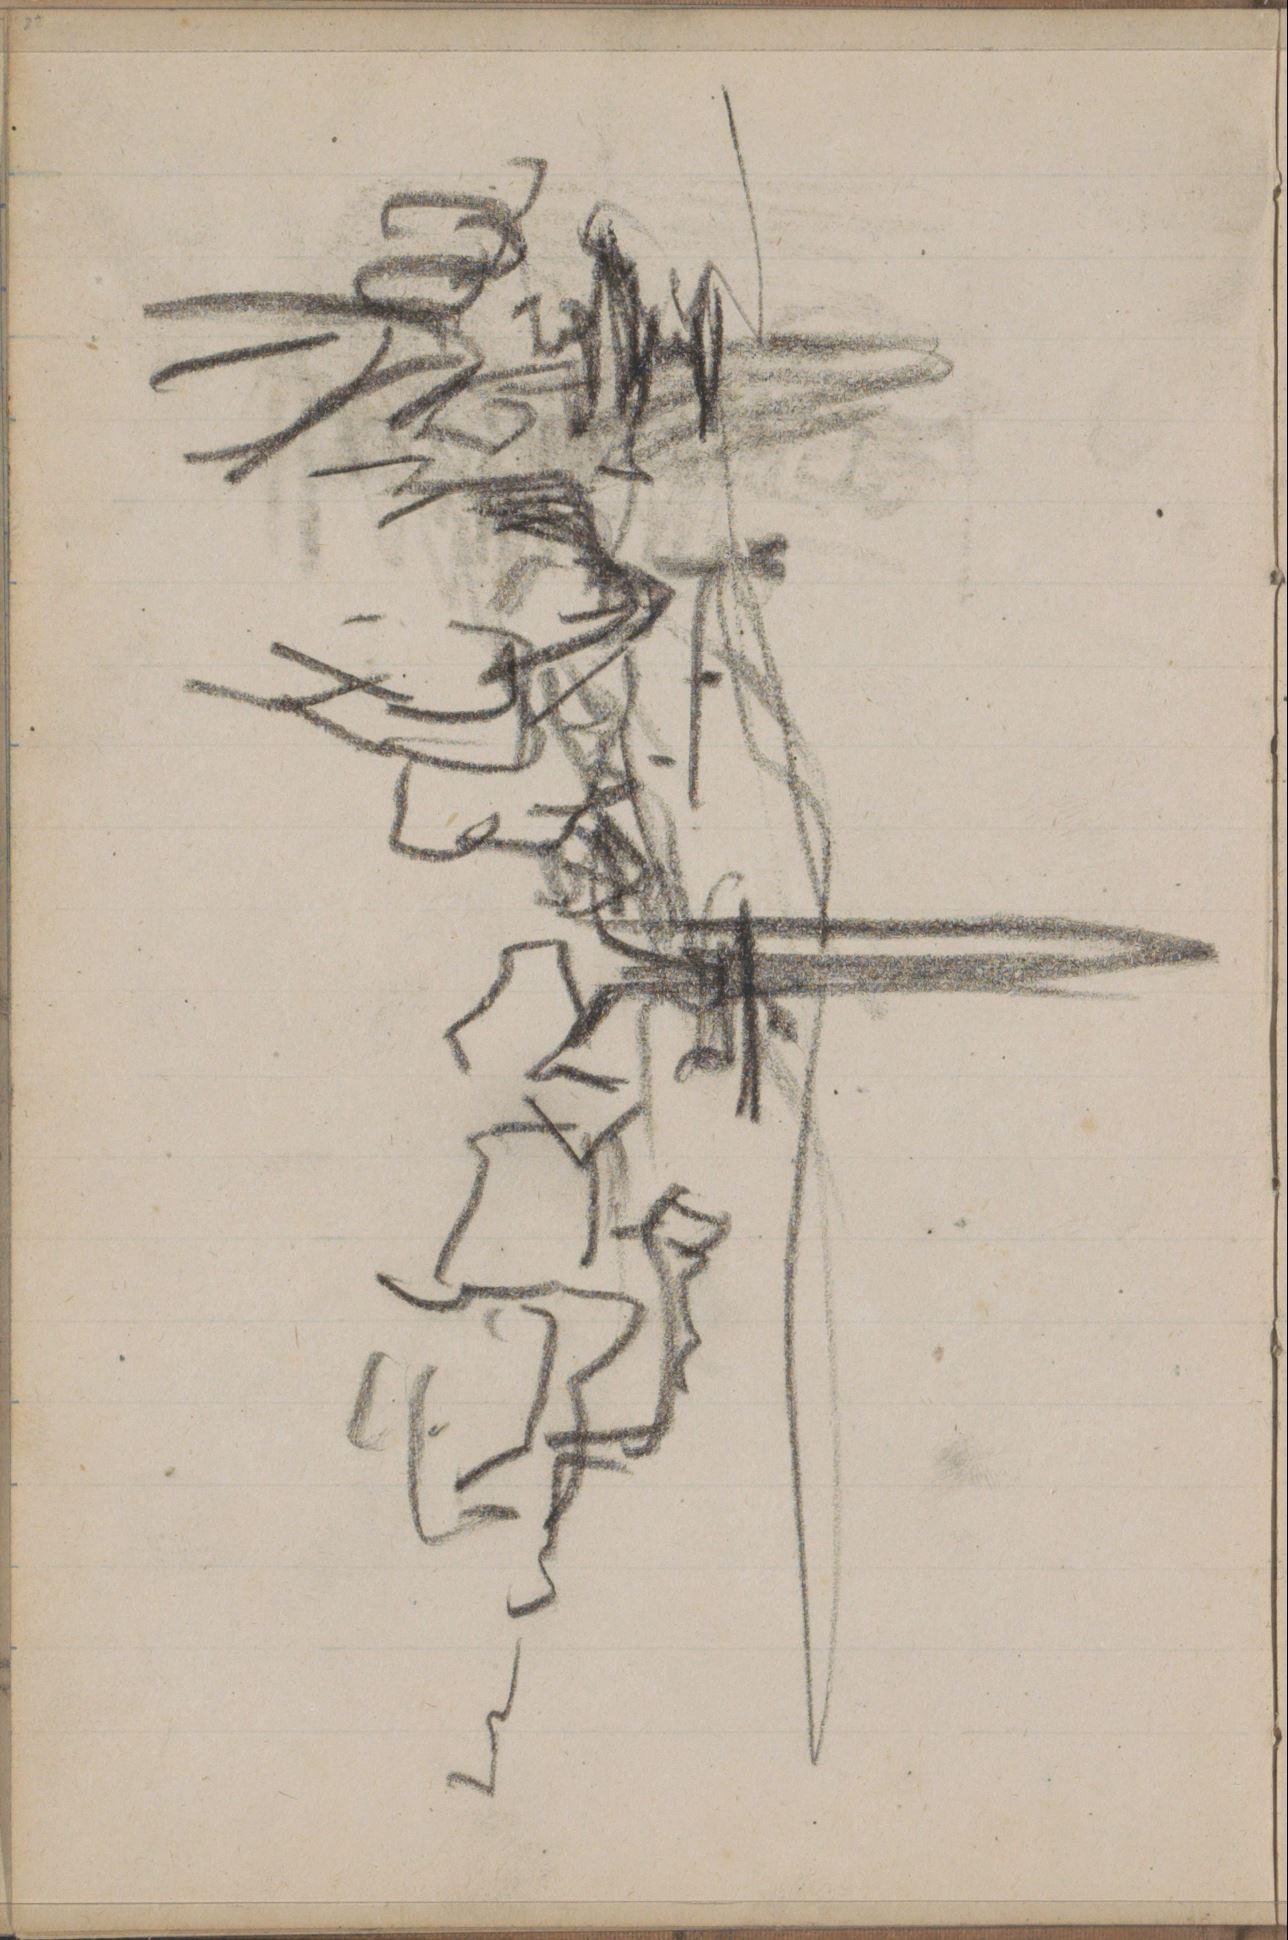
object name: sketchbook leaf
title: Studieblad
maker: marius bauer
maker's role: draughtsman, print maker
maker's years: 1867-1932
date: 1888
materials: chalk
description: Pagina 22 uit een schetsboek met 49 bladen.